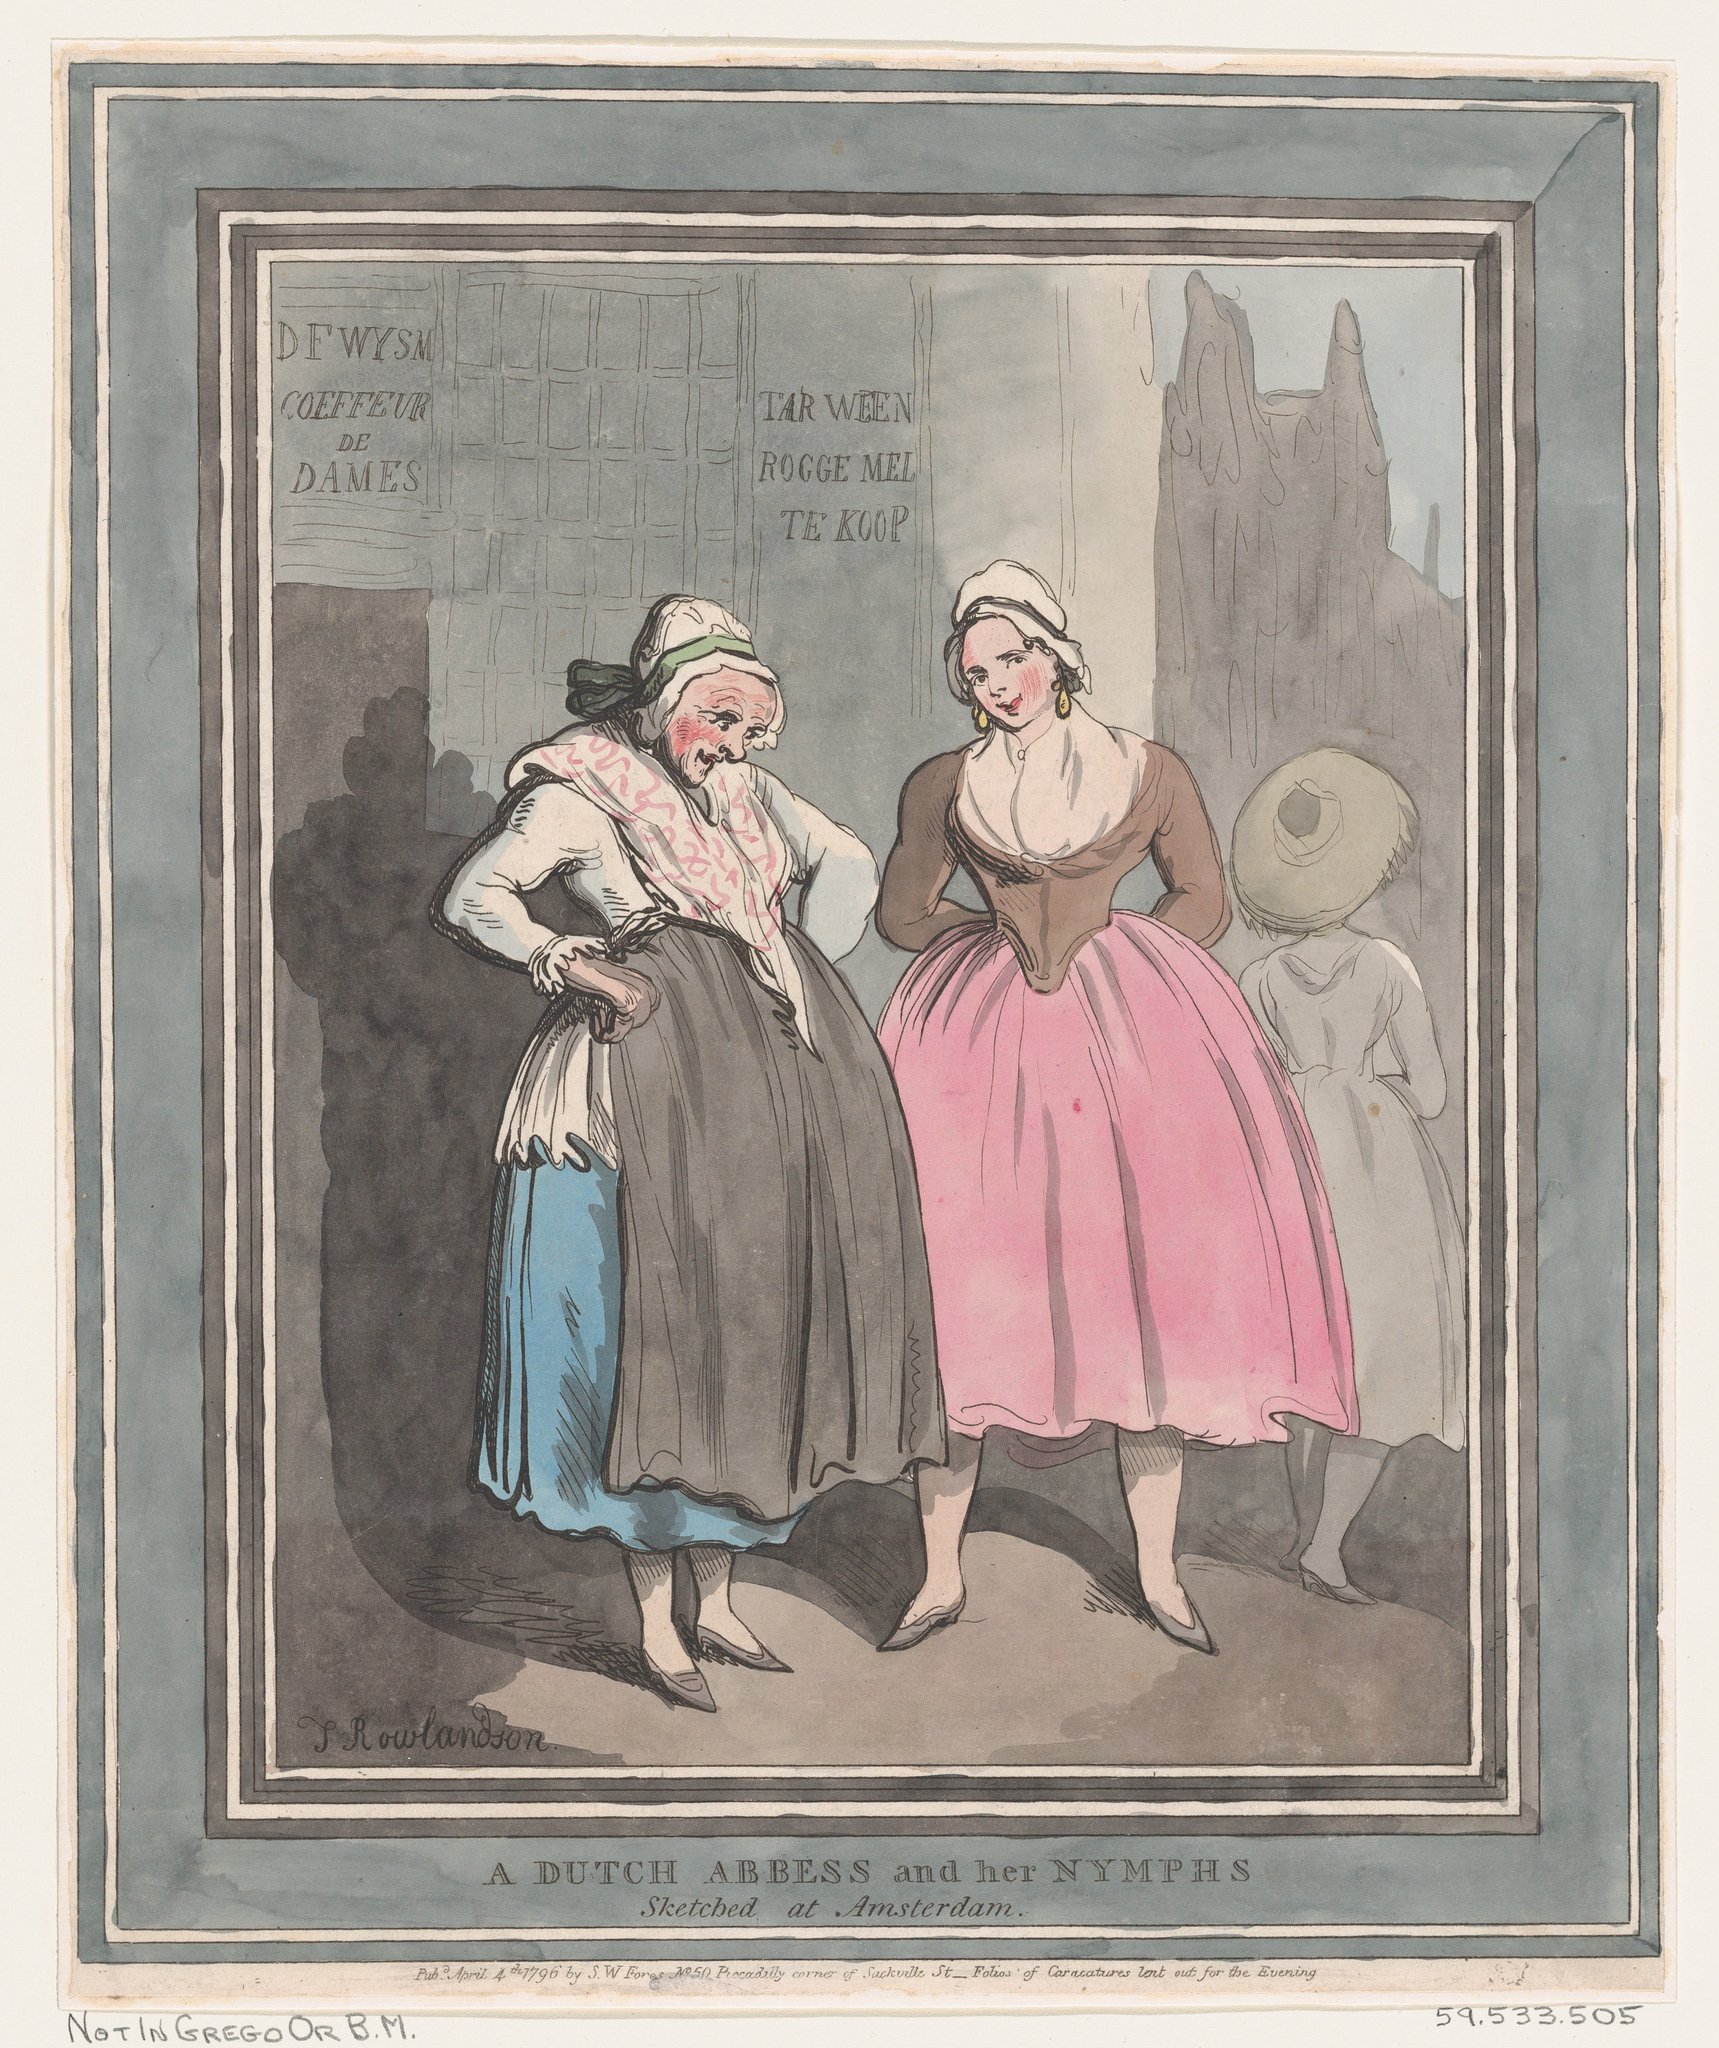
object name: print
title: A Dutch Abbess and her Nymphs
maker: thomas rowlandson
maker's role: artist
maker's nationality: british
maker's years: 1757-1827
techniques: etching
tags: satire,women